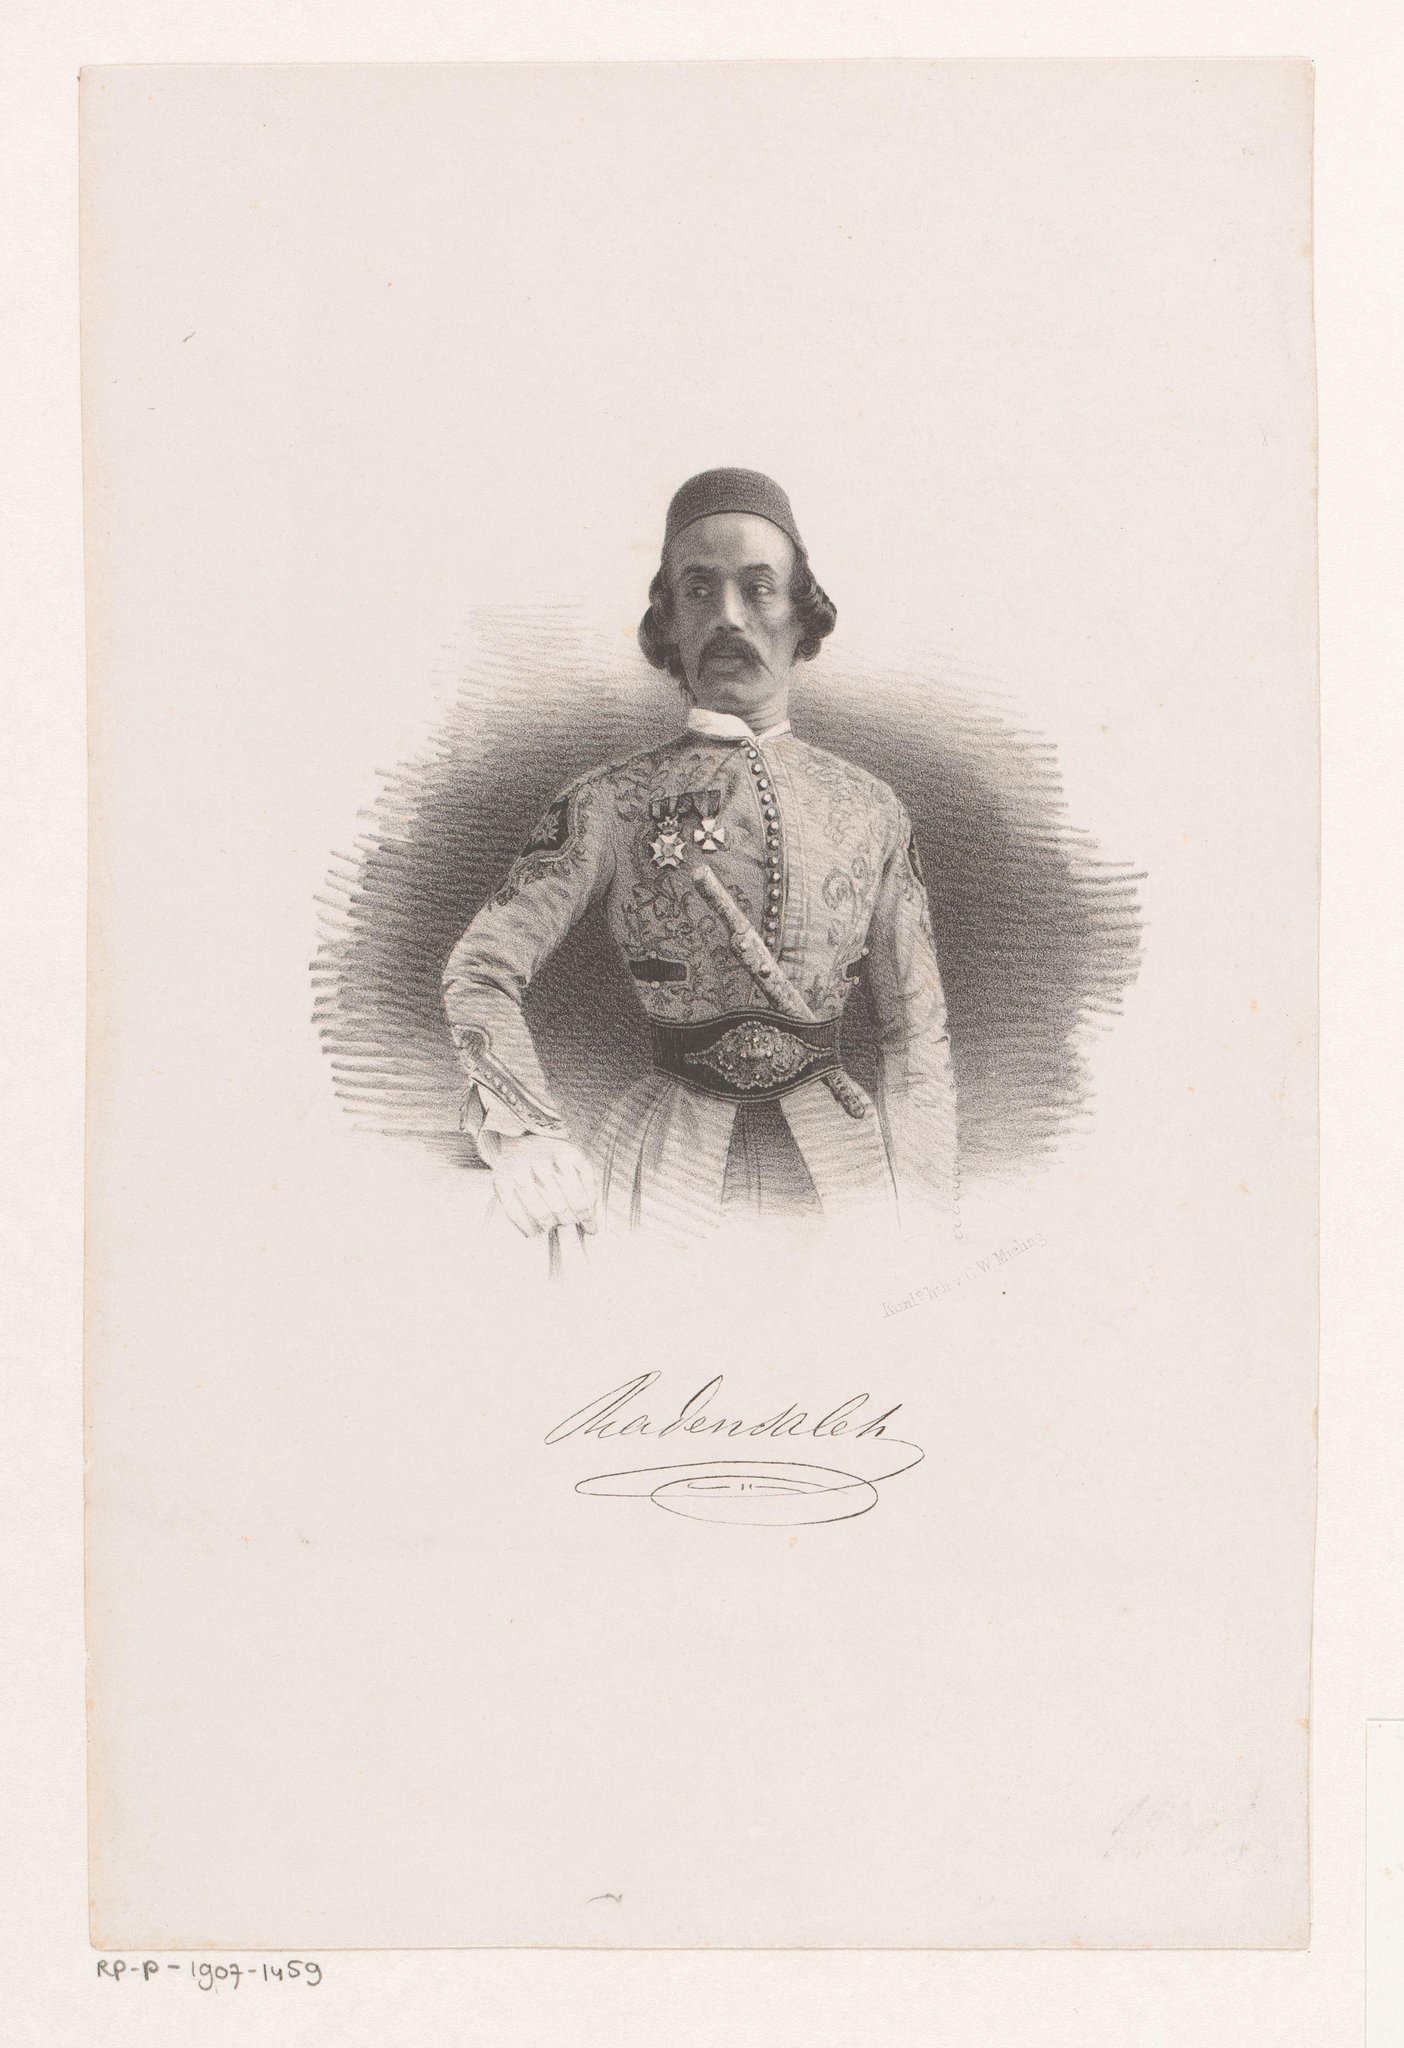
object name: print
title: Portret van Raden Saleh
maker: Anonymous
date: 1847-1865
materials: paper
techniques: lithograph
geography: the hague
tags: painter, draughtsman, raden sarief bastaman saleh, knighthood order, historical persons (+ half-length portrait), tools, aids, implements ~ crafts and industries: knife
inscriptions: collector's mark: Lugt 2228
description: De geportretteerde draagt een galakostuum, ridderorden en een kris. Onder het portret de signatuur van de geportretteerde.